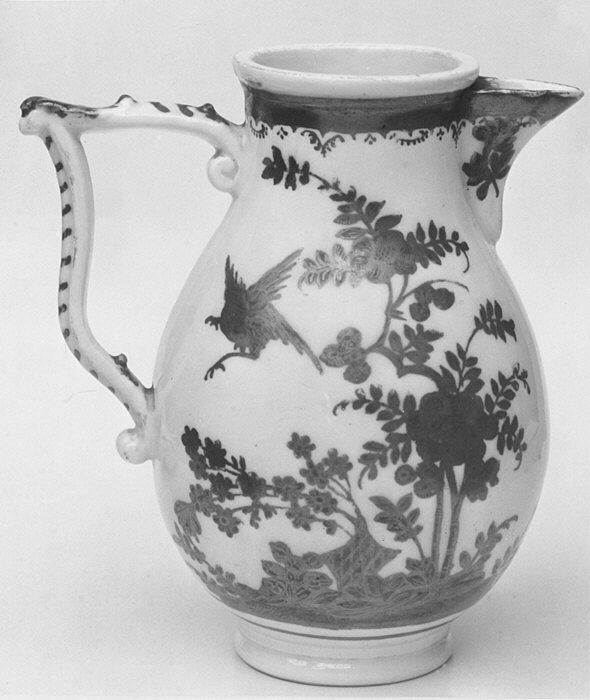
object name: chocolate pot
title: Chocolate pot (?)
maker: meissen manufactory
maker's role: manufactory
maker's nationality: german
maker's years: 1710-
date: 1740-1750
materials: hard paste porcelain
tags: birds,flowers,plants